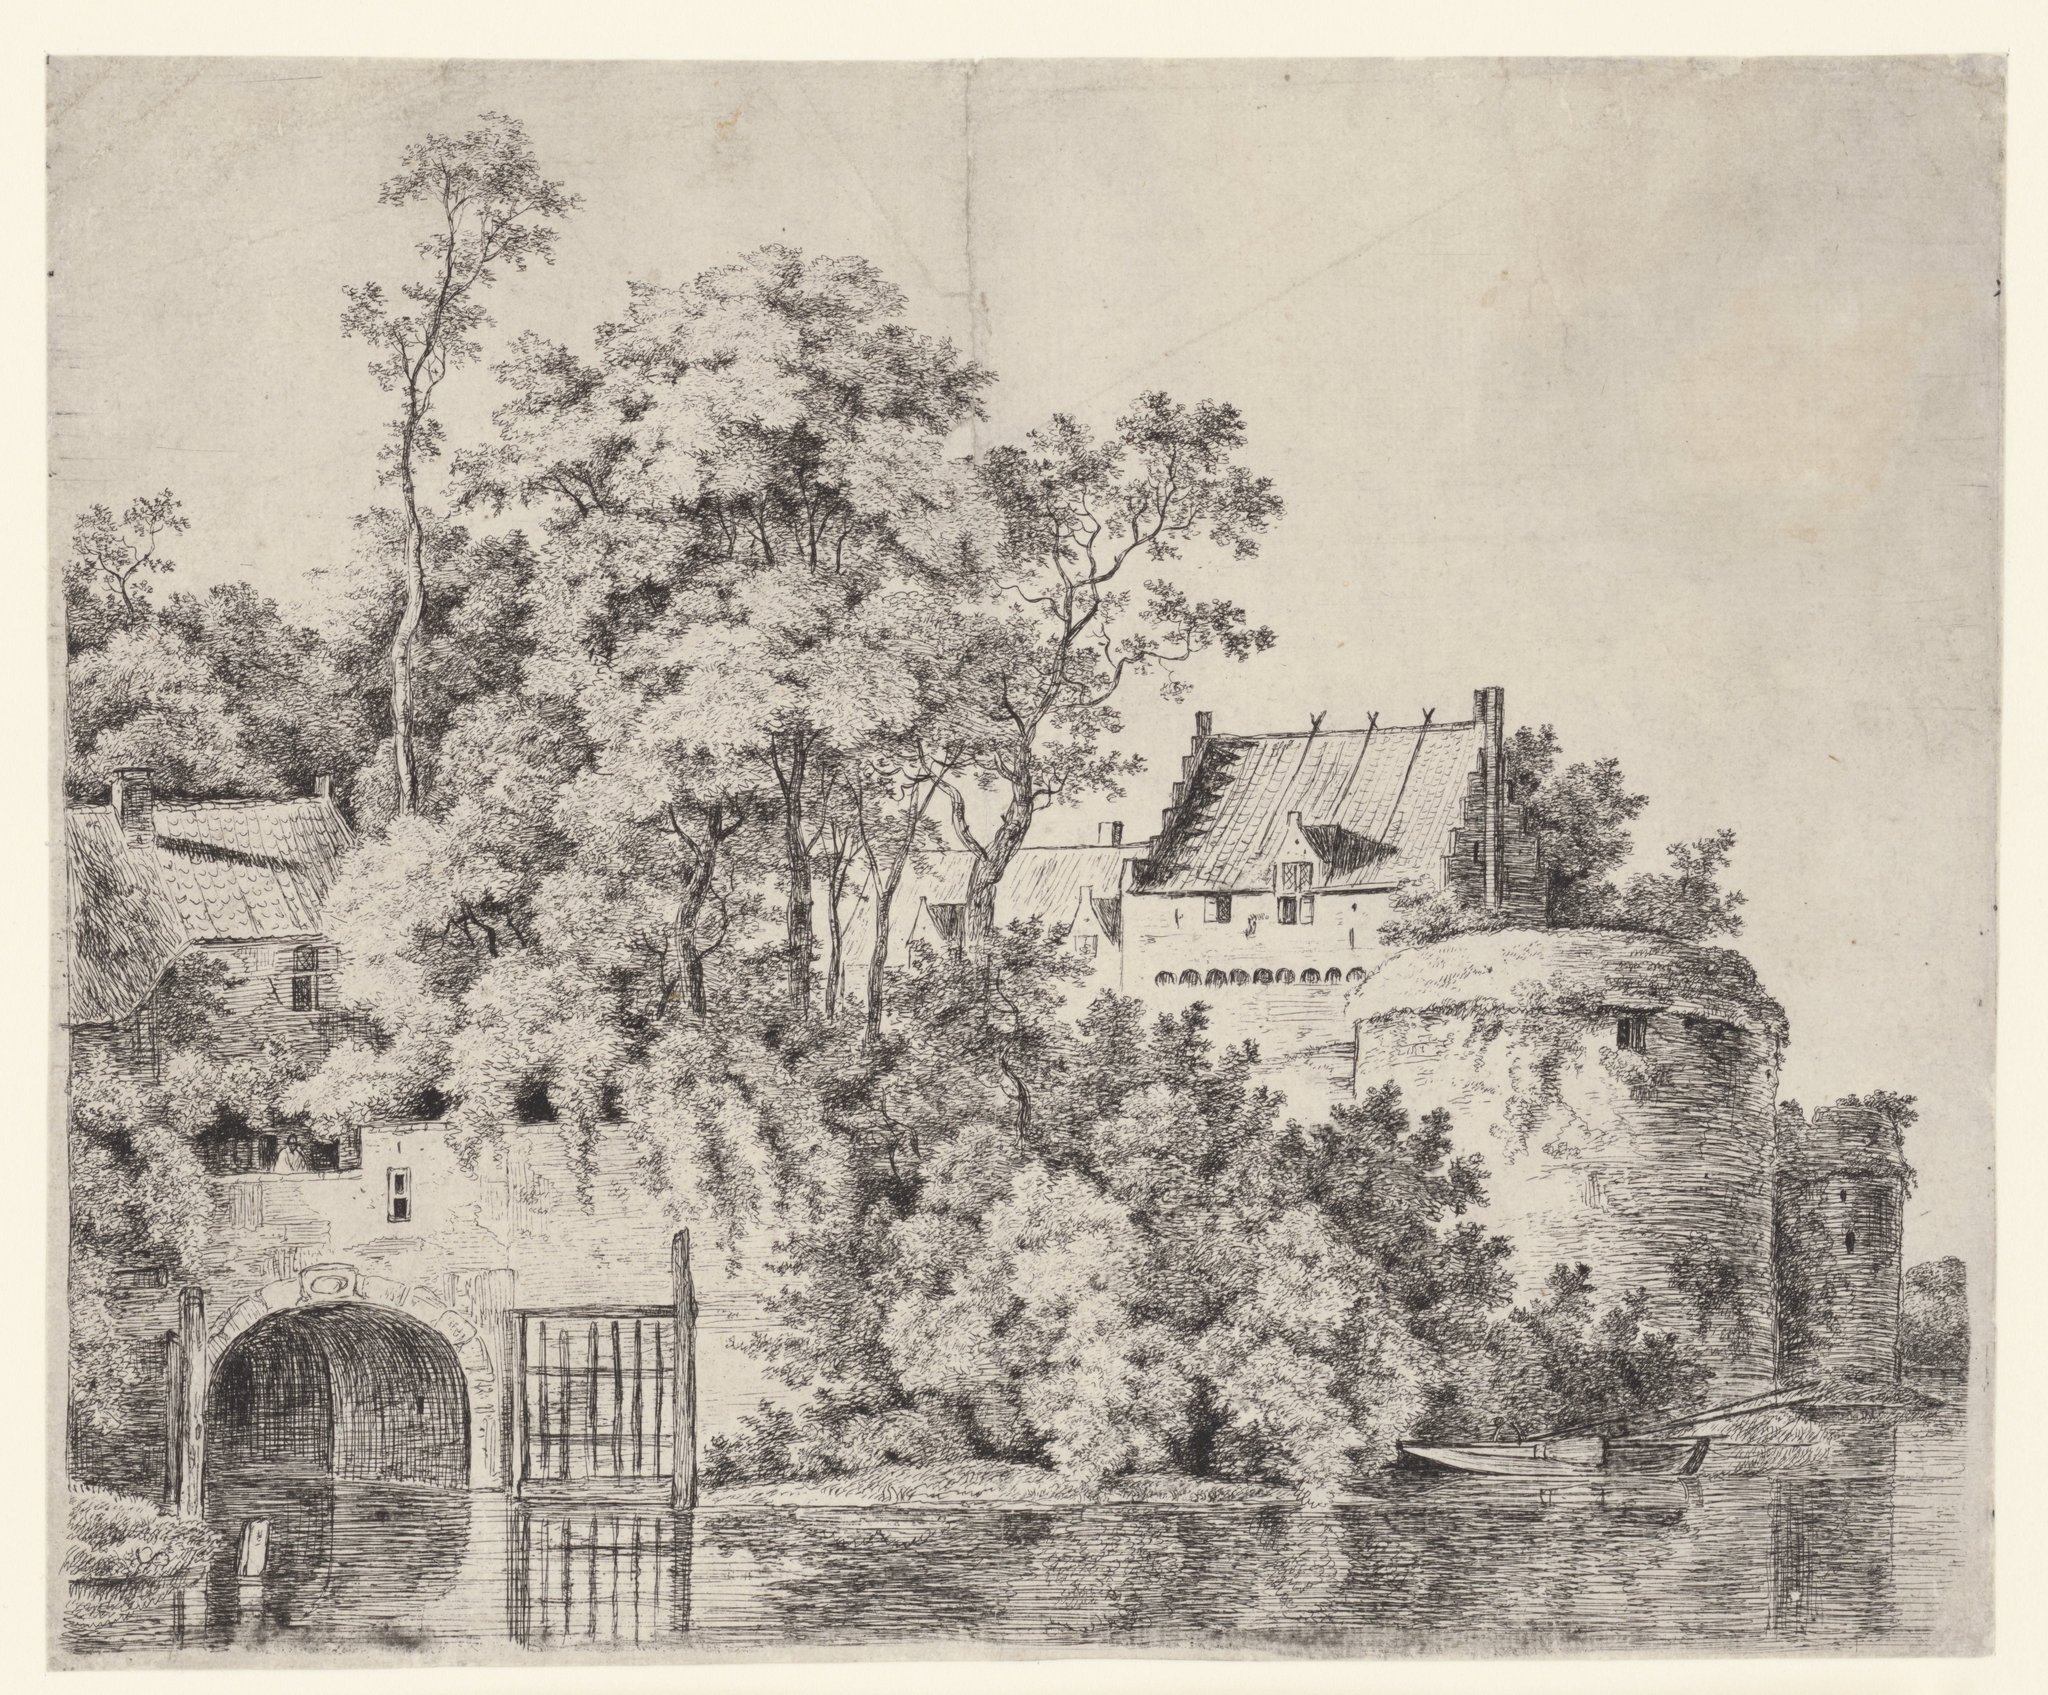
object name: print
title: Het kasteel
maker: jan hackaert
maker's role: draughtsman, painter, print maker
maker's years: 1628-1705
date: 1640-1699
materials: paper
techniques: etching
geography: netherlands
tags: river bank, city-gate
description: Stadspoort van Gorkum, eerste prent uit een serie van zes landschappen